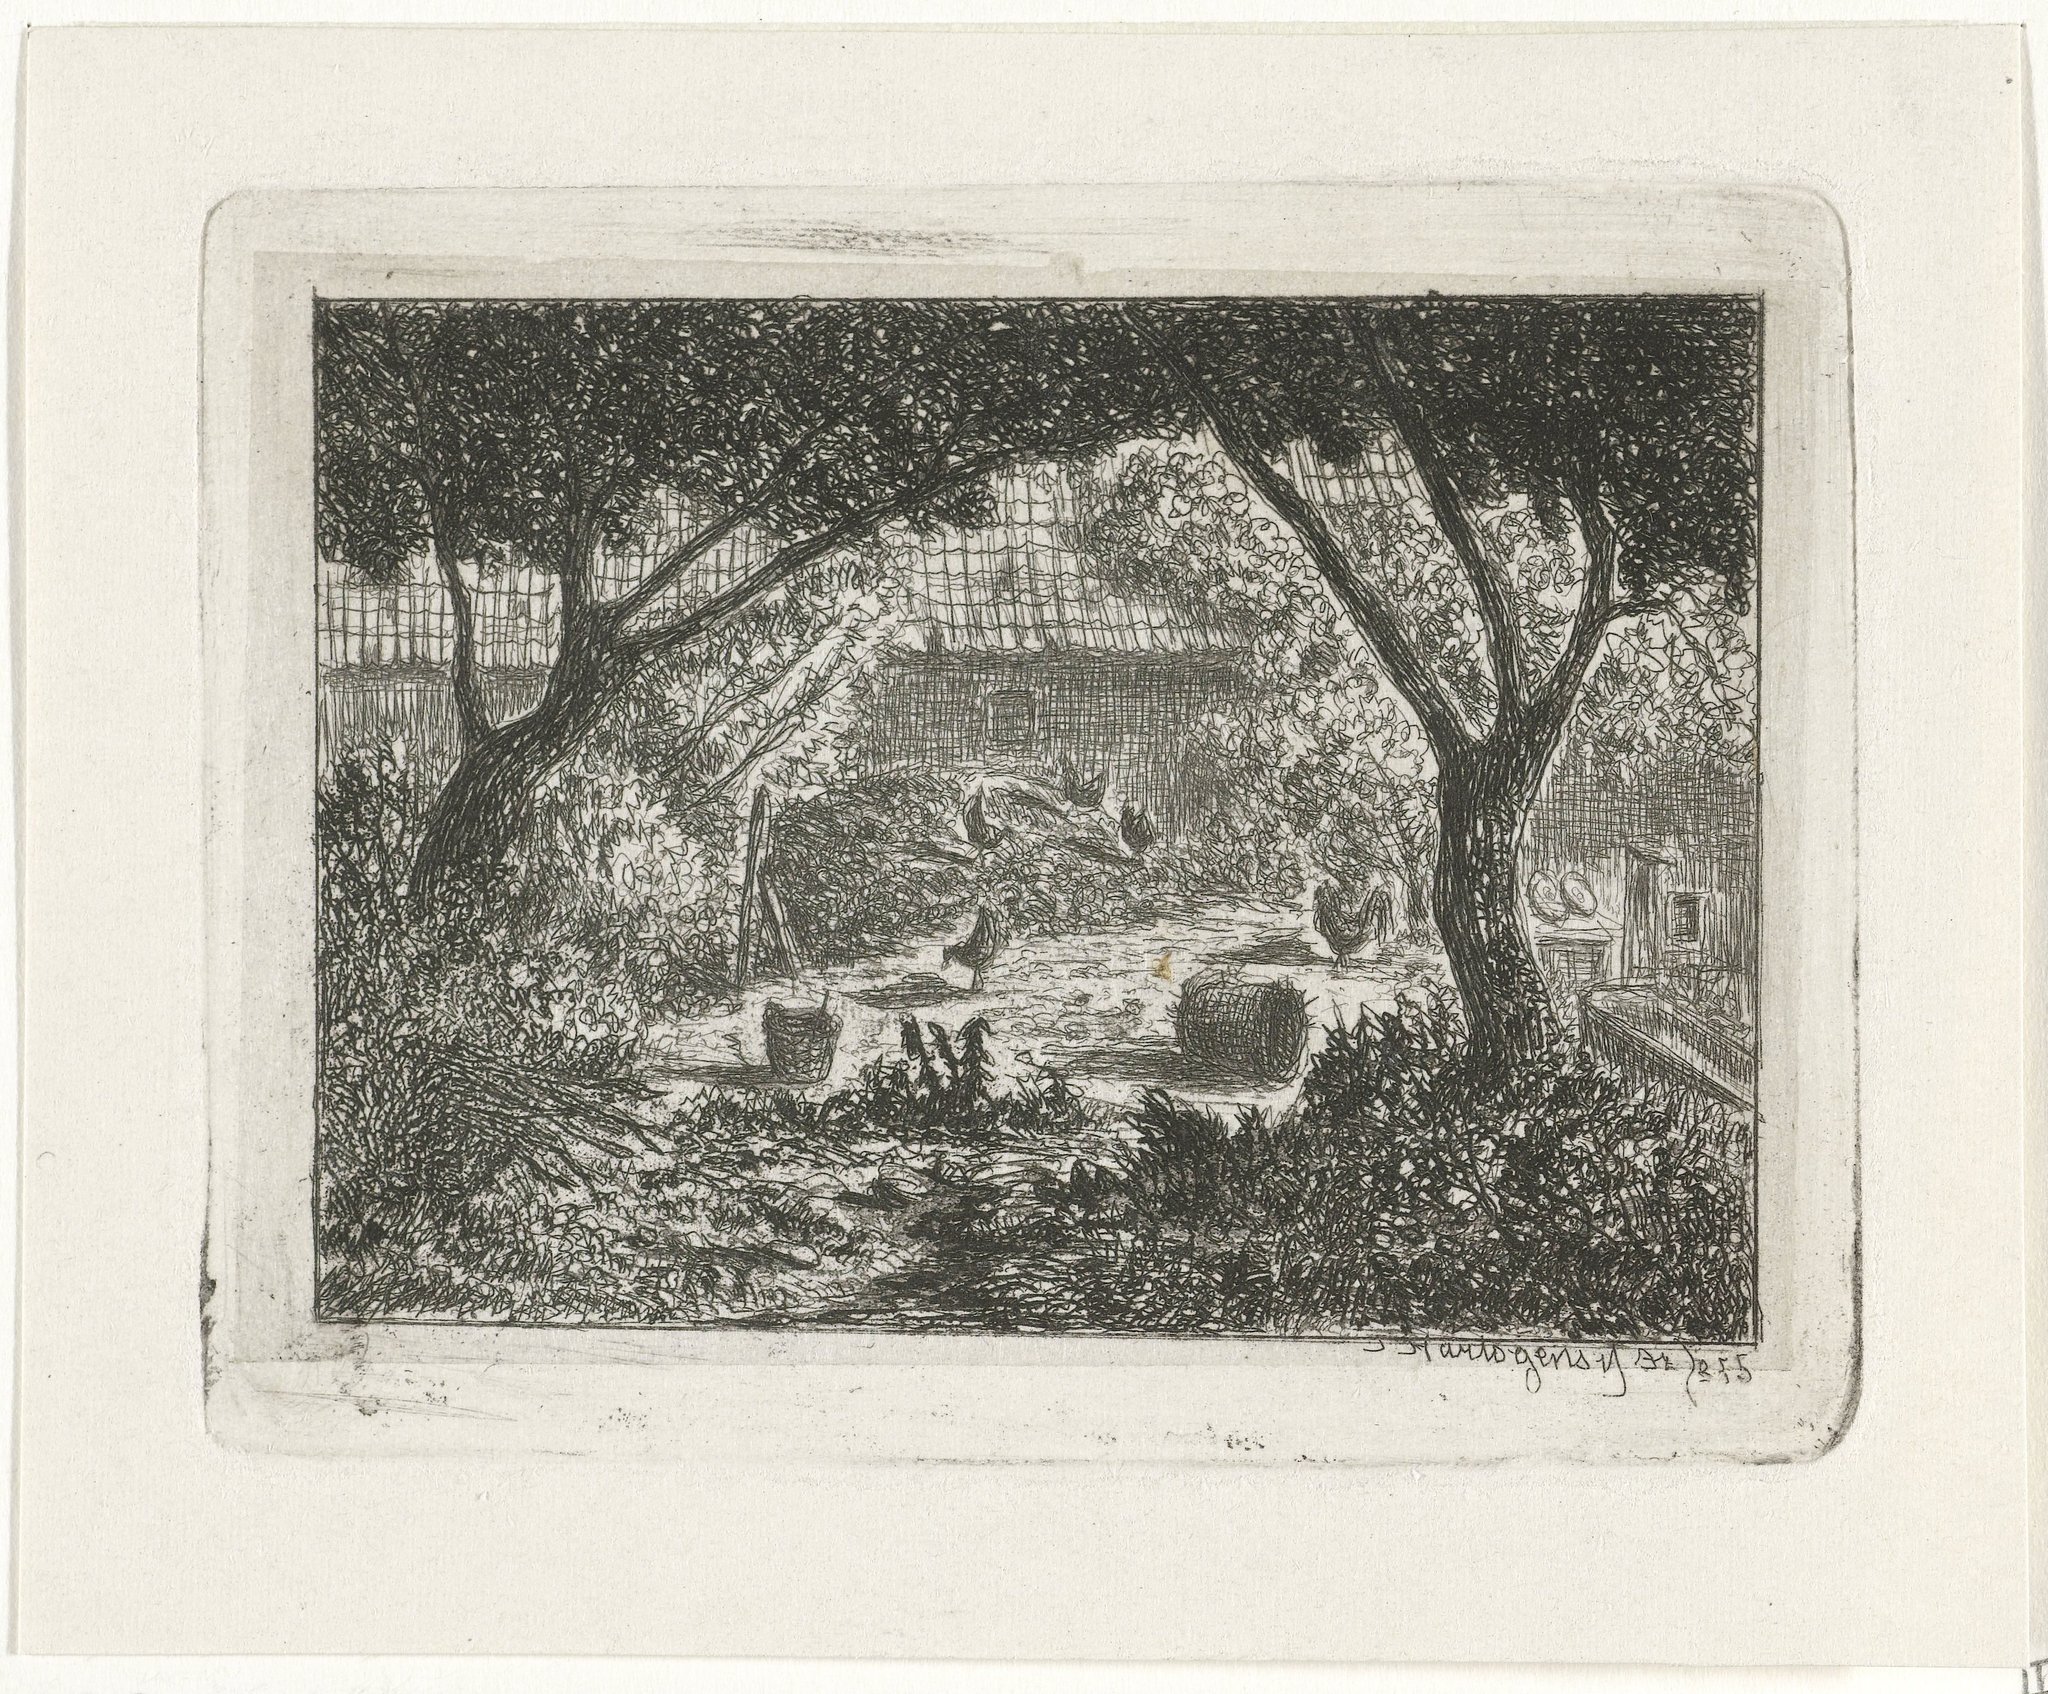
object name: print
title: Boerenerf met kippen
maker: joseph hartogensis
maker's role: painter, print maker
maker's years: 1822-1865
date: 1855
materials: paper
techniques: etching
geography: the hague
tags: fowl (cock, hen, chicken, etc.), farm (building)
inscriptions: collector's mark: Lugt 2228